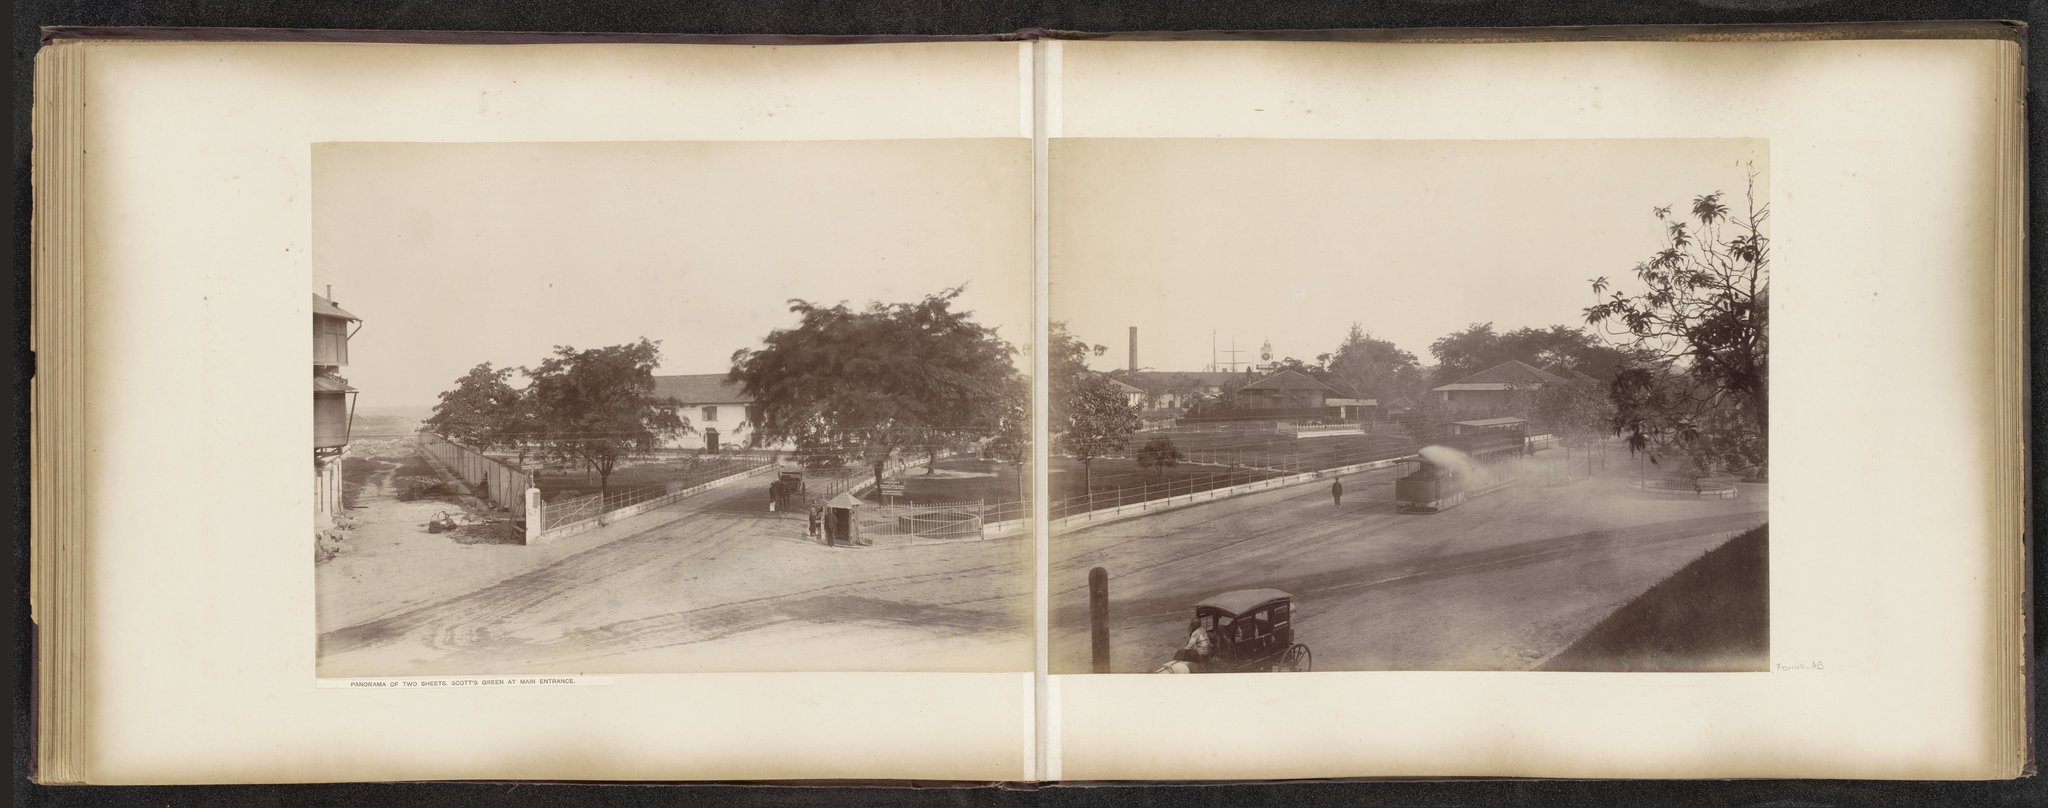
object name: panoramic photograph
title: Gezicht op Scott's Green, de ingang van de Tanjong Pagar Dock Co. Ltd. in Singapore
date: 1890-1905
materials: photographic support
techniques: albumen print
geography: singapore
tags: tramway, tram, gate, entrance, public road, singapore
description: Panoramafoto bestaande uit twee afdrukken. Onderdeel van Fotoalbum van de Tanjong Pagar Dock Co. Ltd. in Singapore.